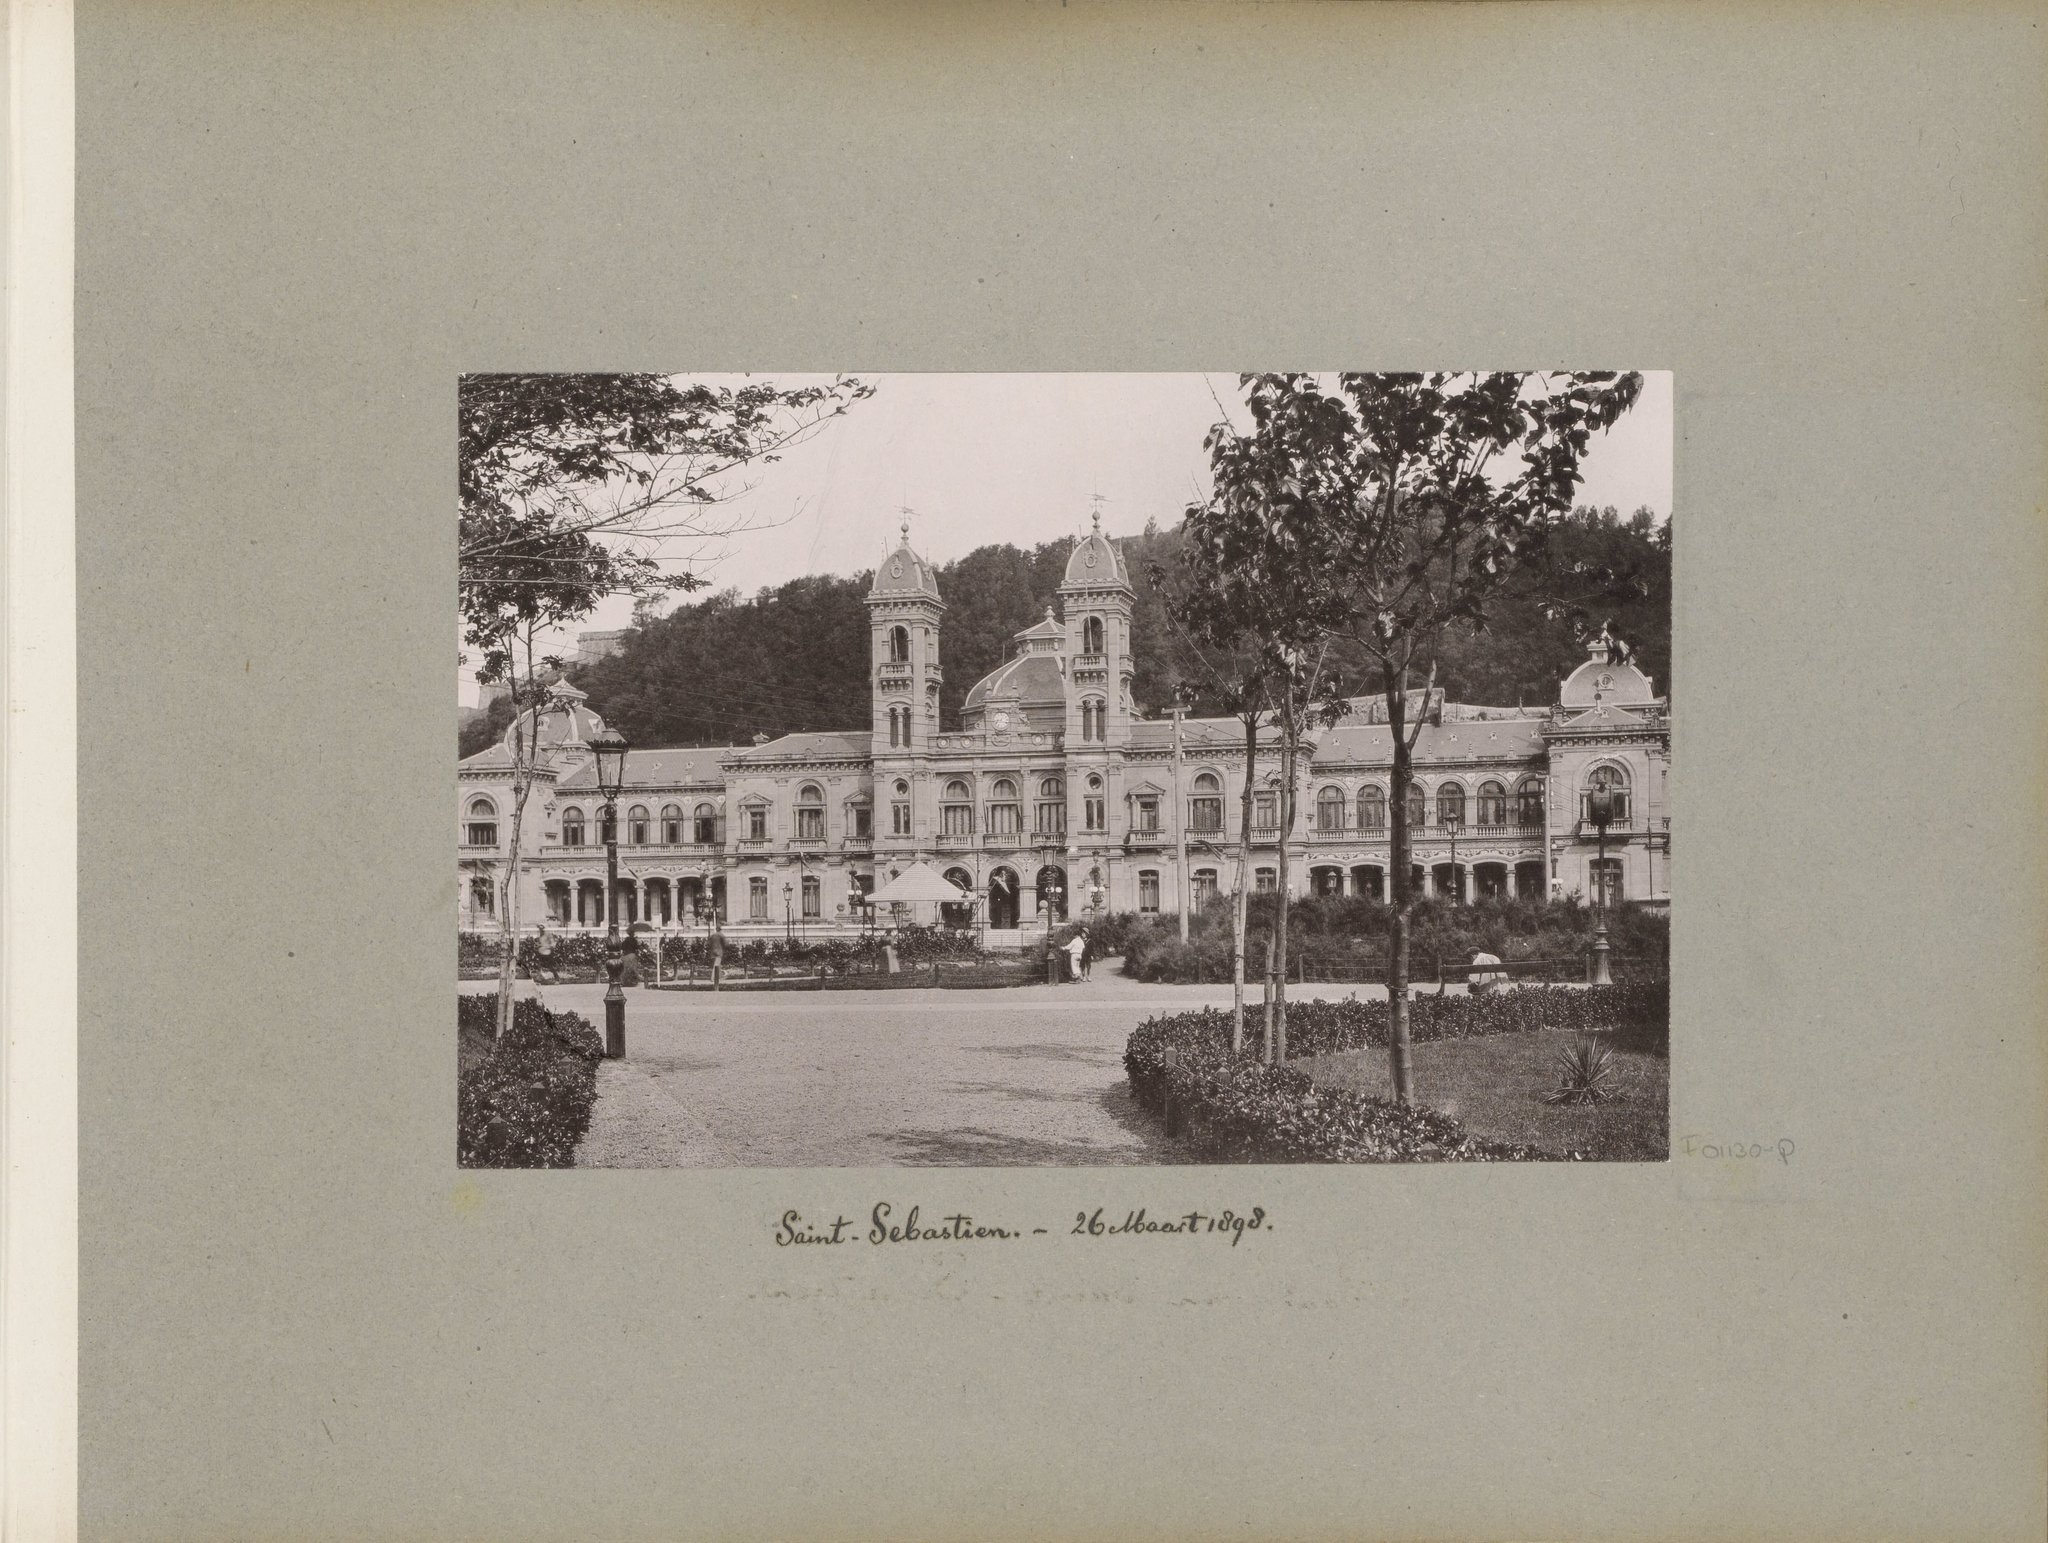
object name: album leaf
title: Exterieur van het casino van San Sebastián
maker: Anonymous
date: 1888-1898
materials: paper, ink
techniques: photograph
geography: donostia-san sebastián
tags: casino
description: Onderdeel van Reisalbum met foto's van bezienswaardigheden in Frankrijk, Spanje, Italië, Duitsland, Zwitserland en Oostenrijk.